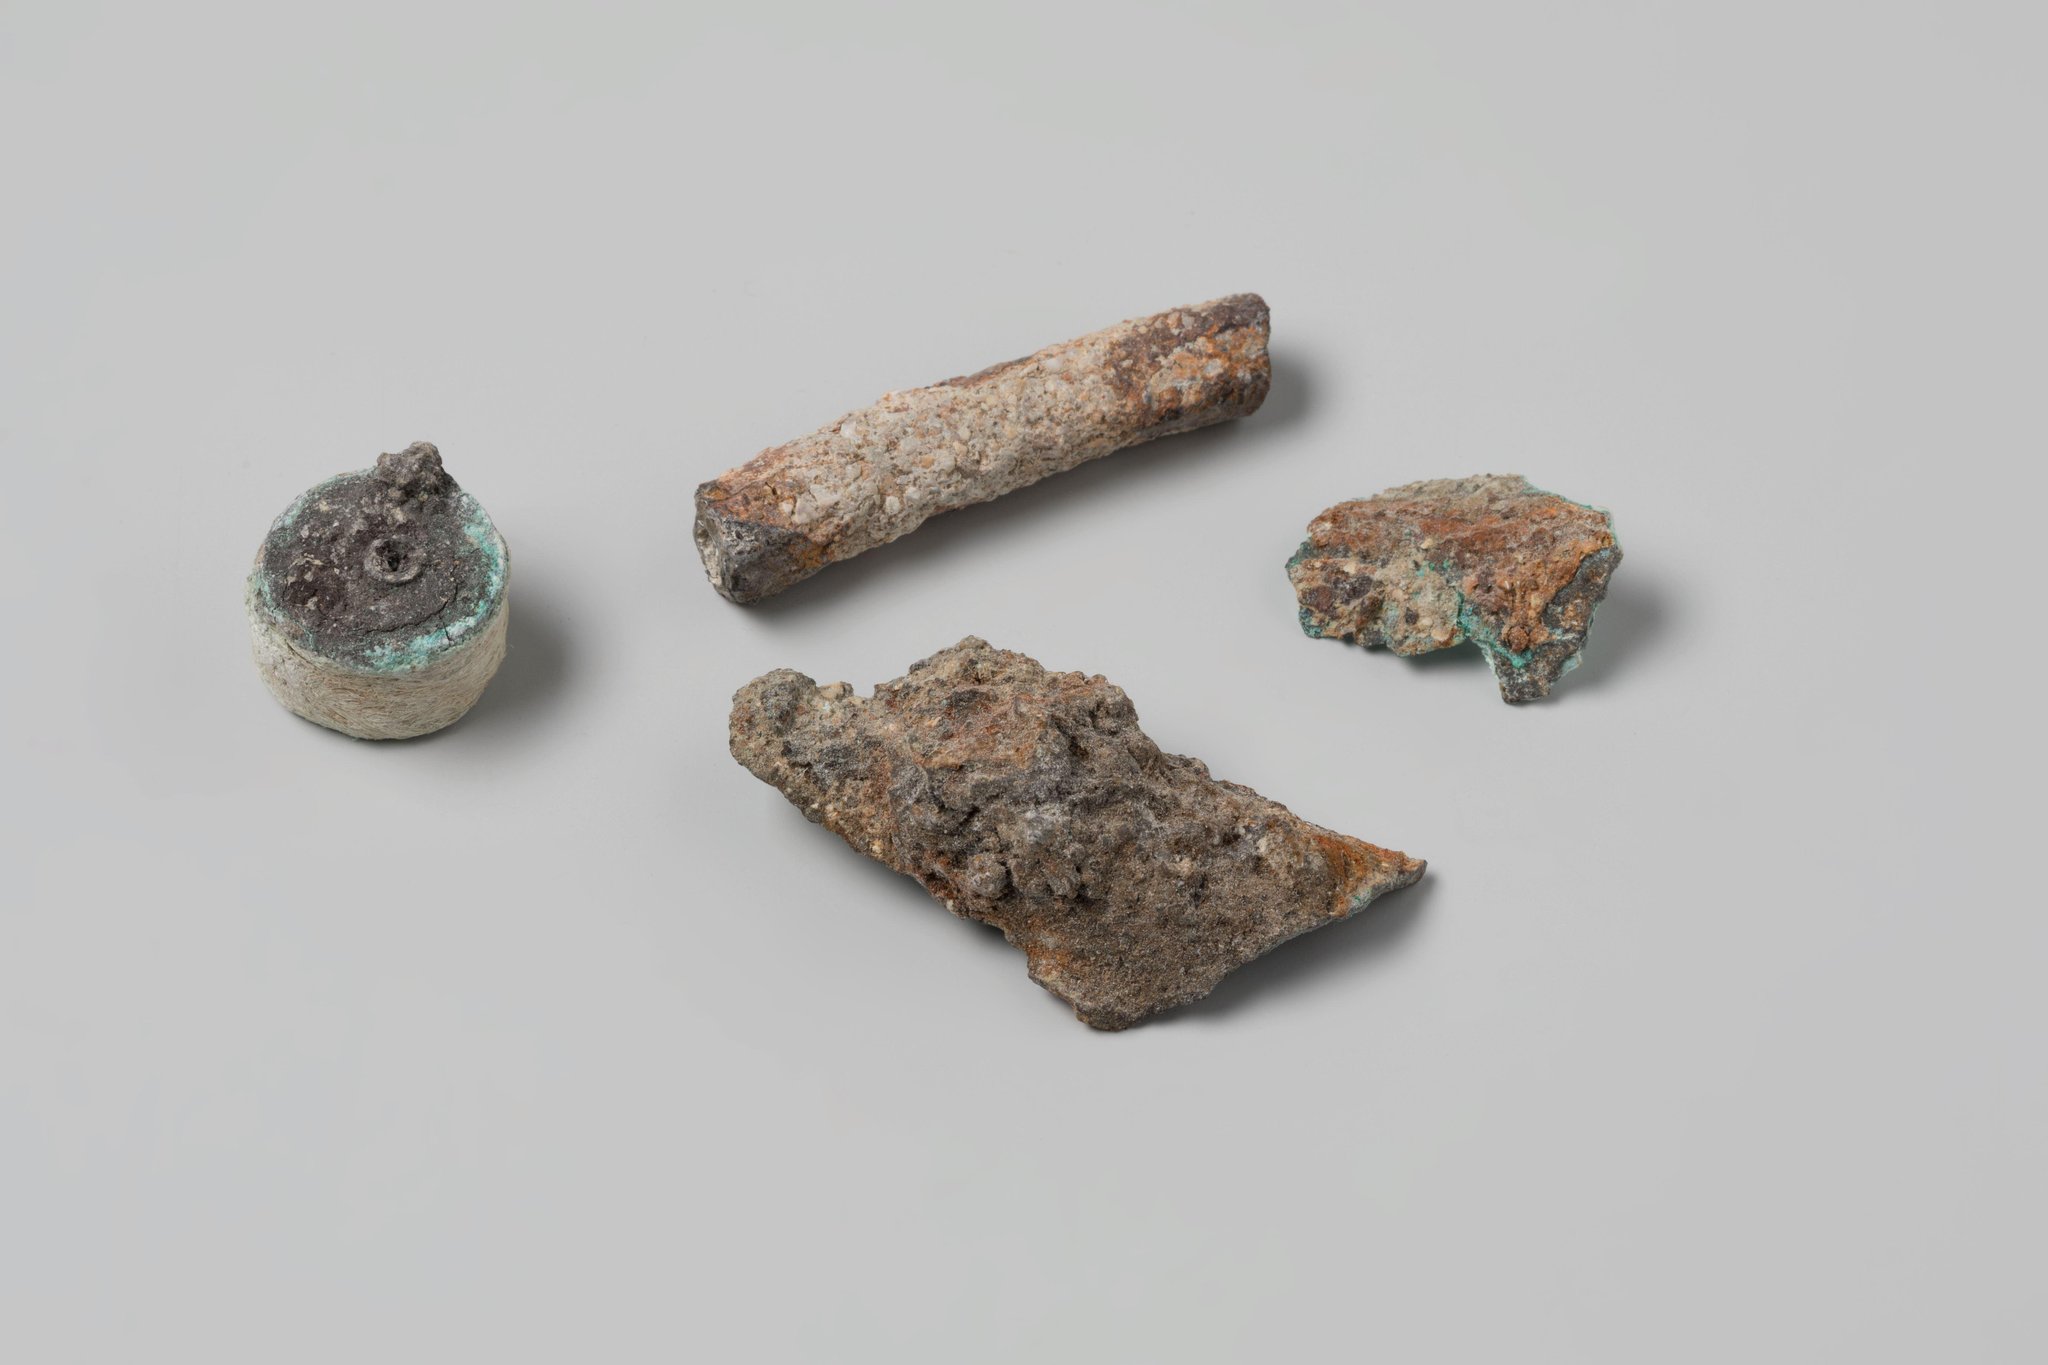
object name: enema syringe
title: Onderdelen klisteerspuit uit het wrak van de Oost-Indiëvaarder Hollandia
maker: Anonymous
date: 1700-1743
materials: tin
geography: netherlands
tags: verenigde oostindische compagnie, hollandia (schip), annet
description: Tools and instruments, medical, enema syringe; fragm of pump system: flat lower end of cylinder with tube-shaped extension underneath broken off, 1 piston, id. NG 1980-27H1633.